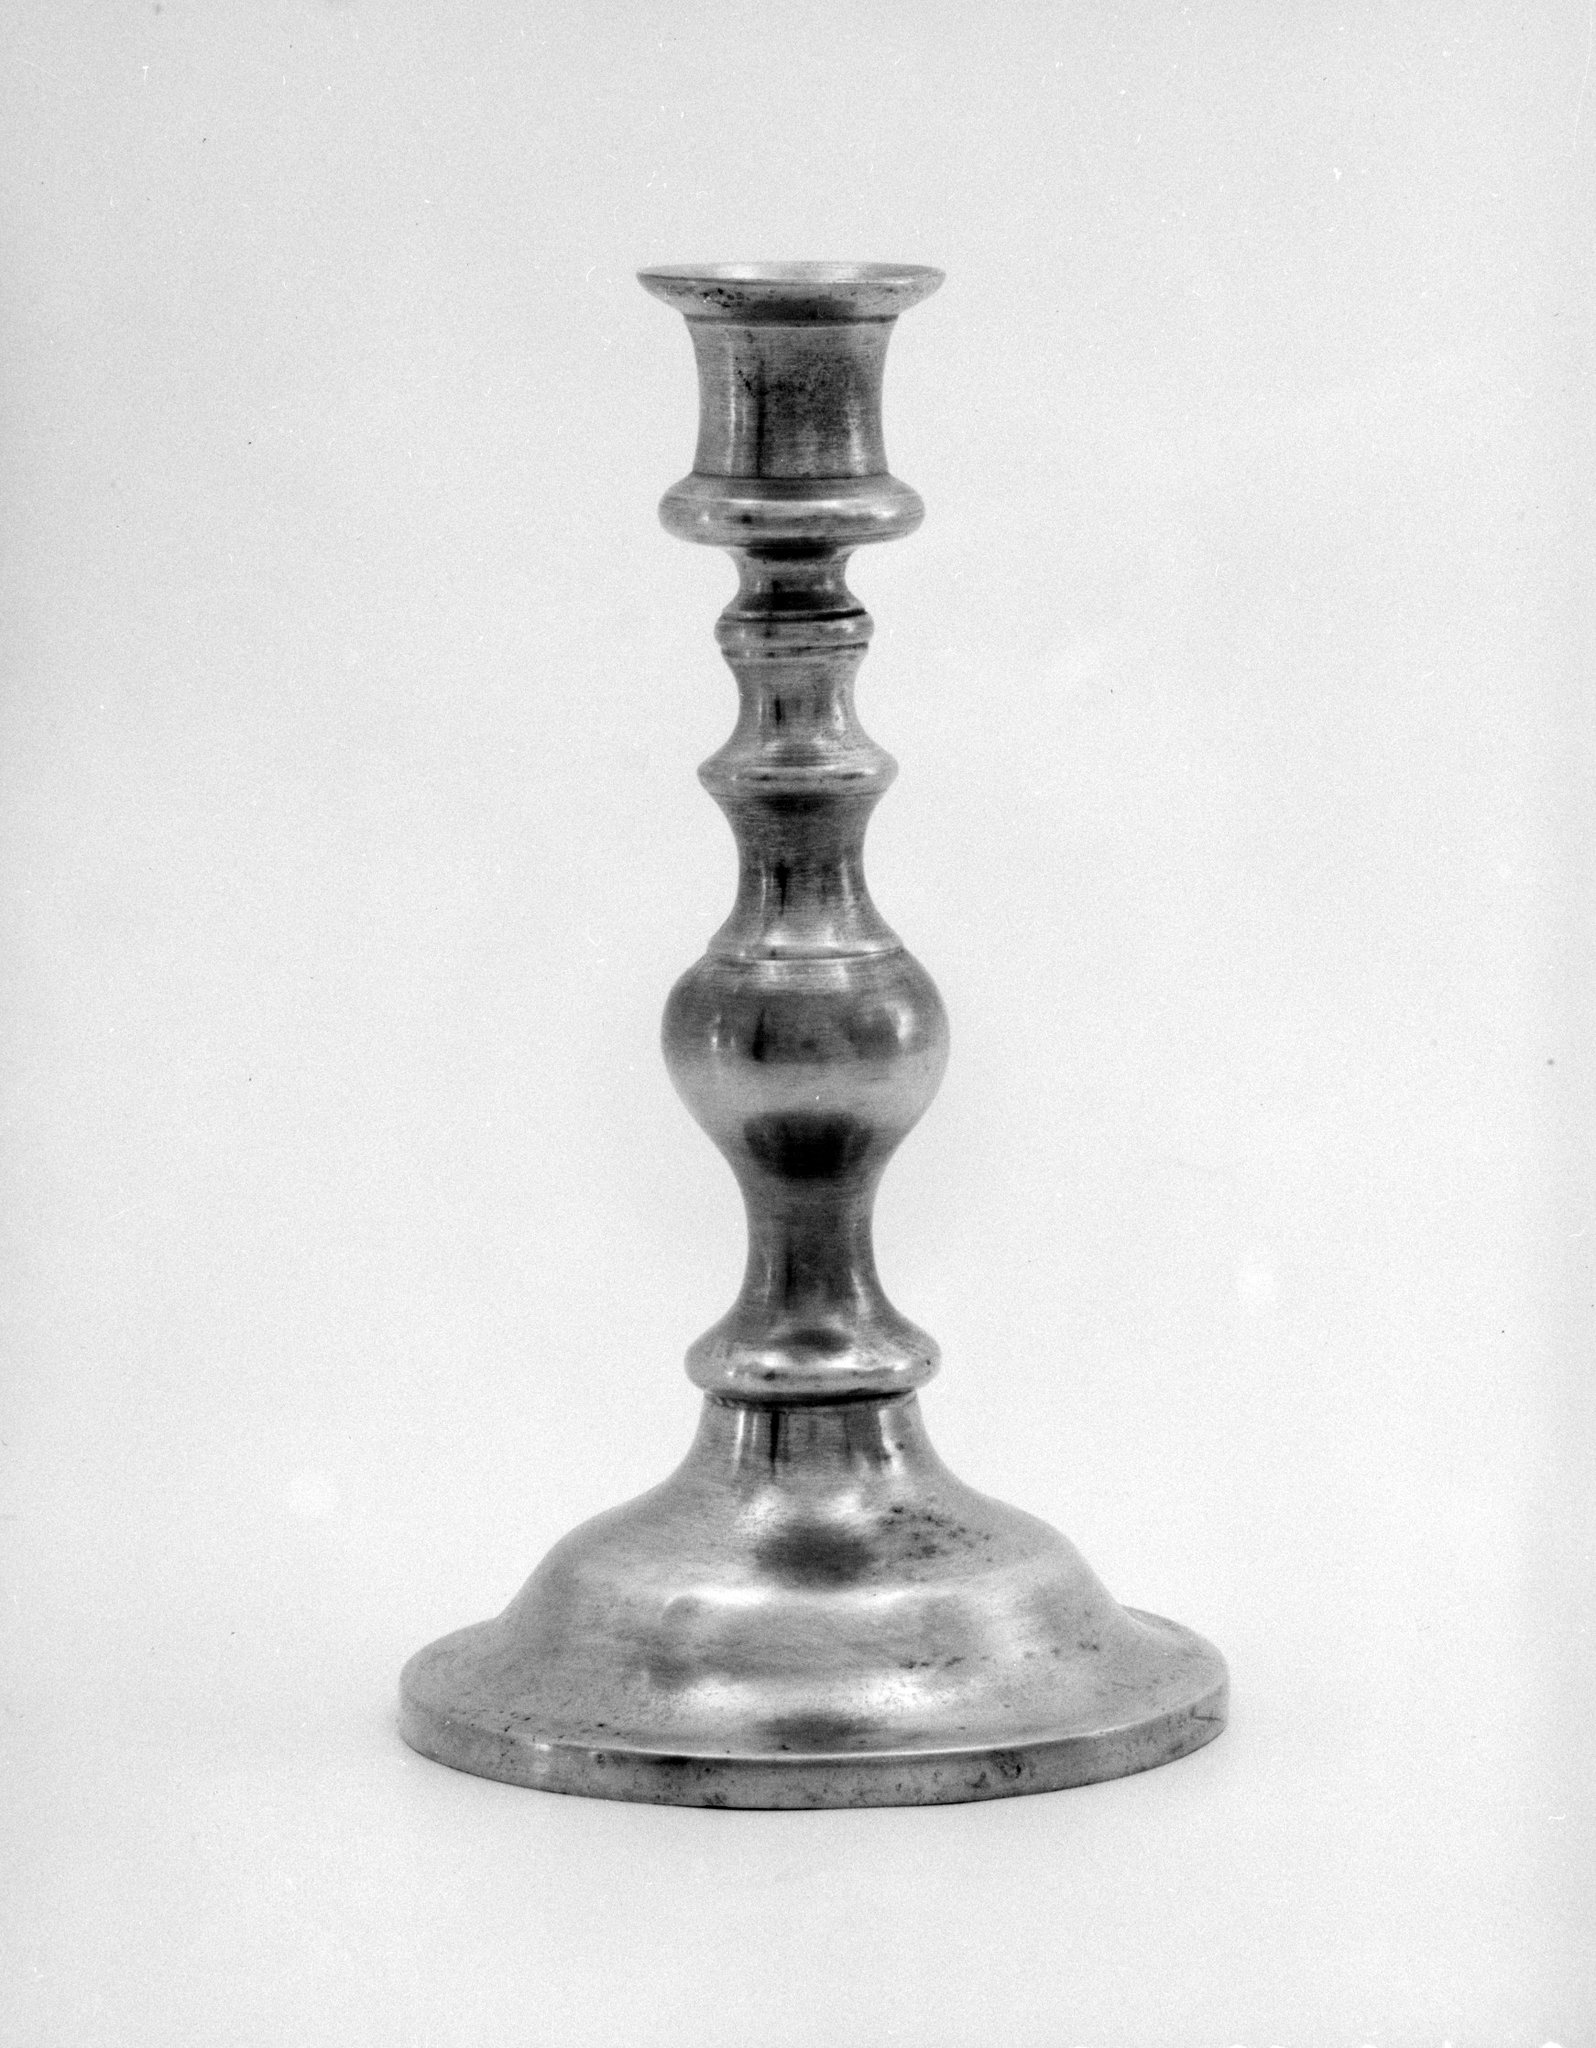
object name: candlestick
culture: american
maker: sellew and company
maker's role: maker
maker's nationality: american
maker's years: 1832-1860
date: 1832-1860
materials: pewter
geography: united states